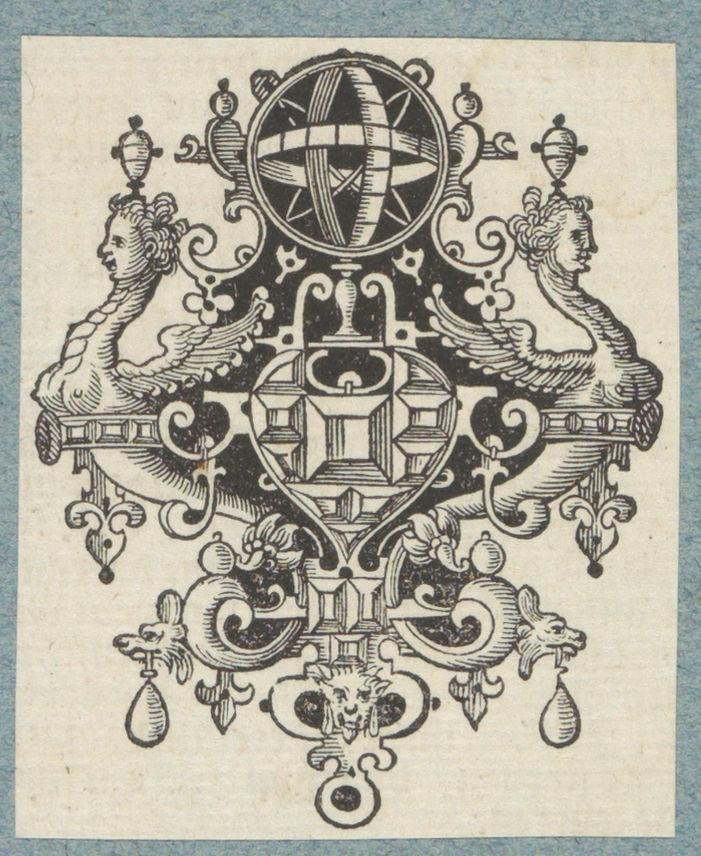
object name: album leaf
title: Ornament met edelstenen en hemelglobe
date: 1597-1667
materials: paper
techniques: letterpress printing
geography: amsterdam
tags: ornamental decoration ~ printed matter, book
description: Afkomstig uit een van de uitgaven van P.J. Paets uit Amsterdam.